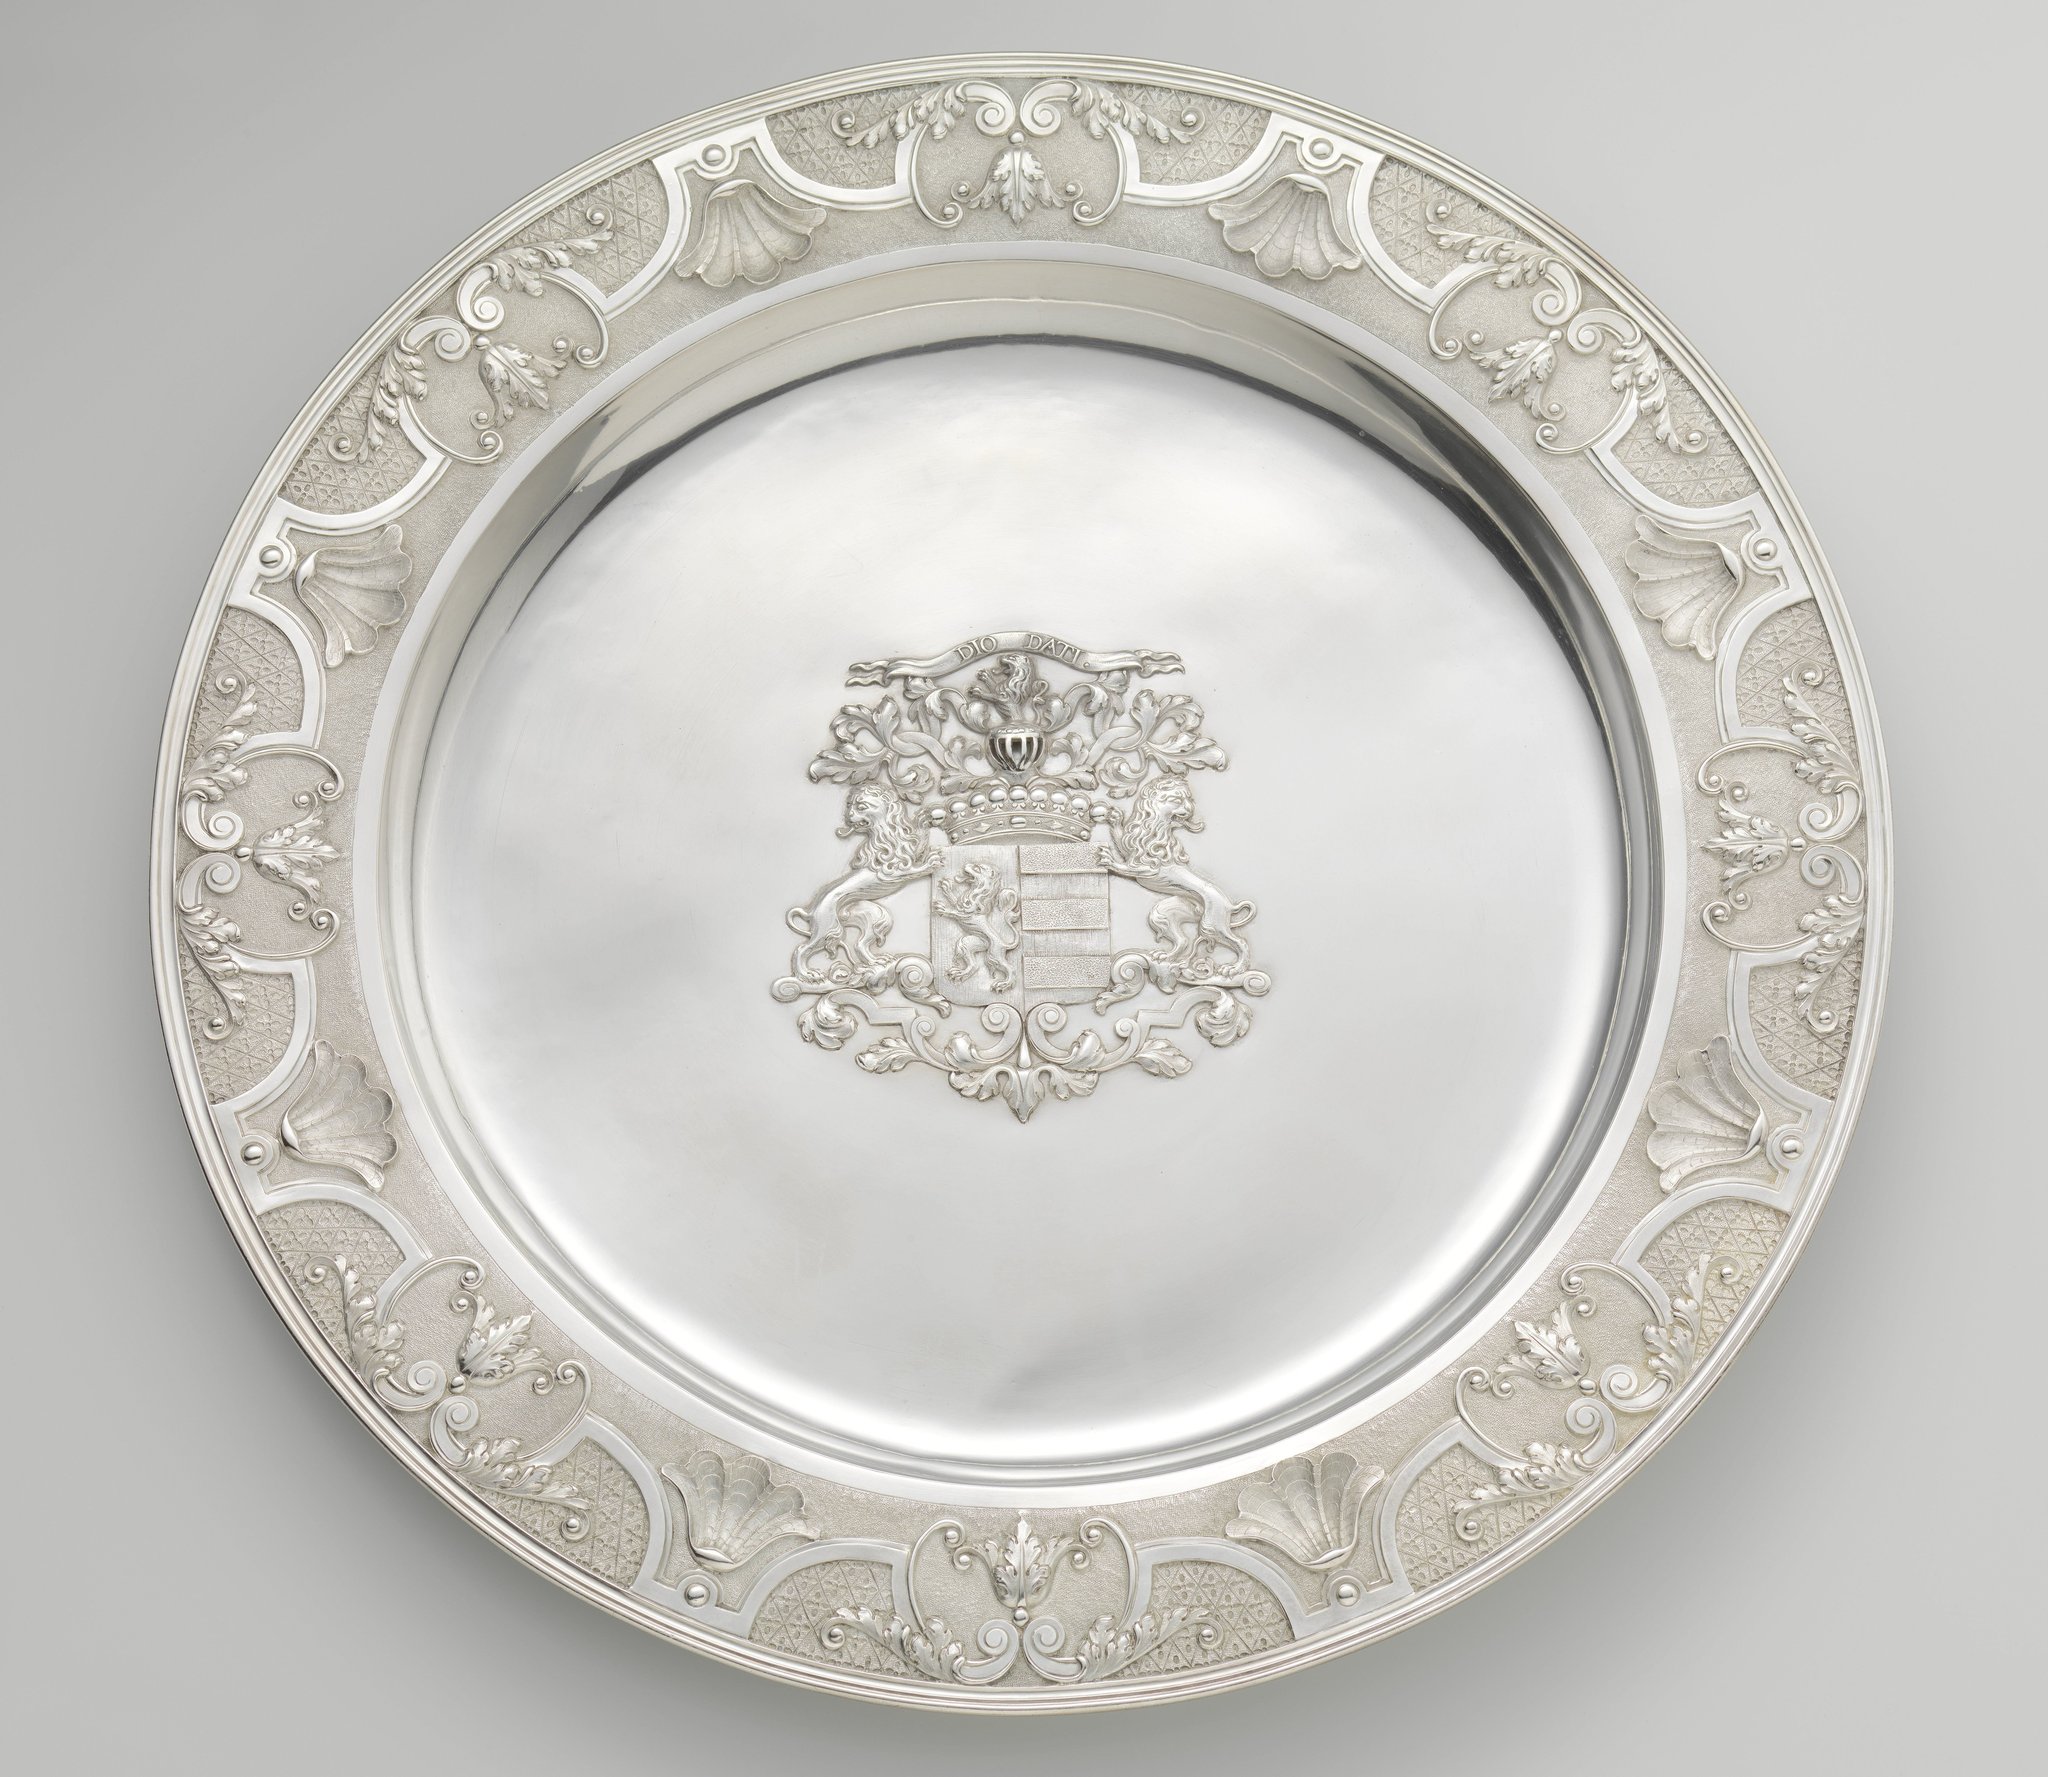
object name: avondmaalsschotel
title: Communion set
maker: dirk wor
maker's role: silversmith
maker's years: 1696-1745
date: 1736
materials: silver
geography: dordrecht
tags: armorial bearing, heraldry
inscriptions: maker's mark, date letter: ‘C’, alloy mark, town mark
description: Central to the Protestant celebration of the Holy Communion is the remembrance of the Last Supper, when Christ and his disciples gathered for the last time. Christ asked that his suffering and death be commemorated with a communal meal. This is why wine is poured into cups and bread is placed on plates during religious services. This communion set from Dordrecht ranks among the most richly decorated altar plate.